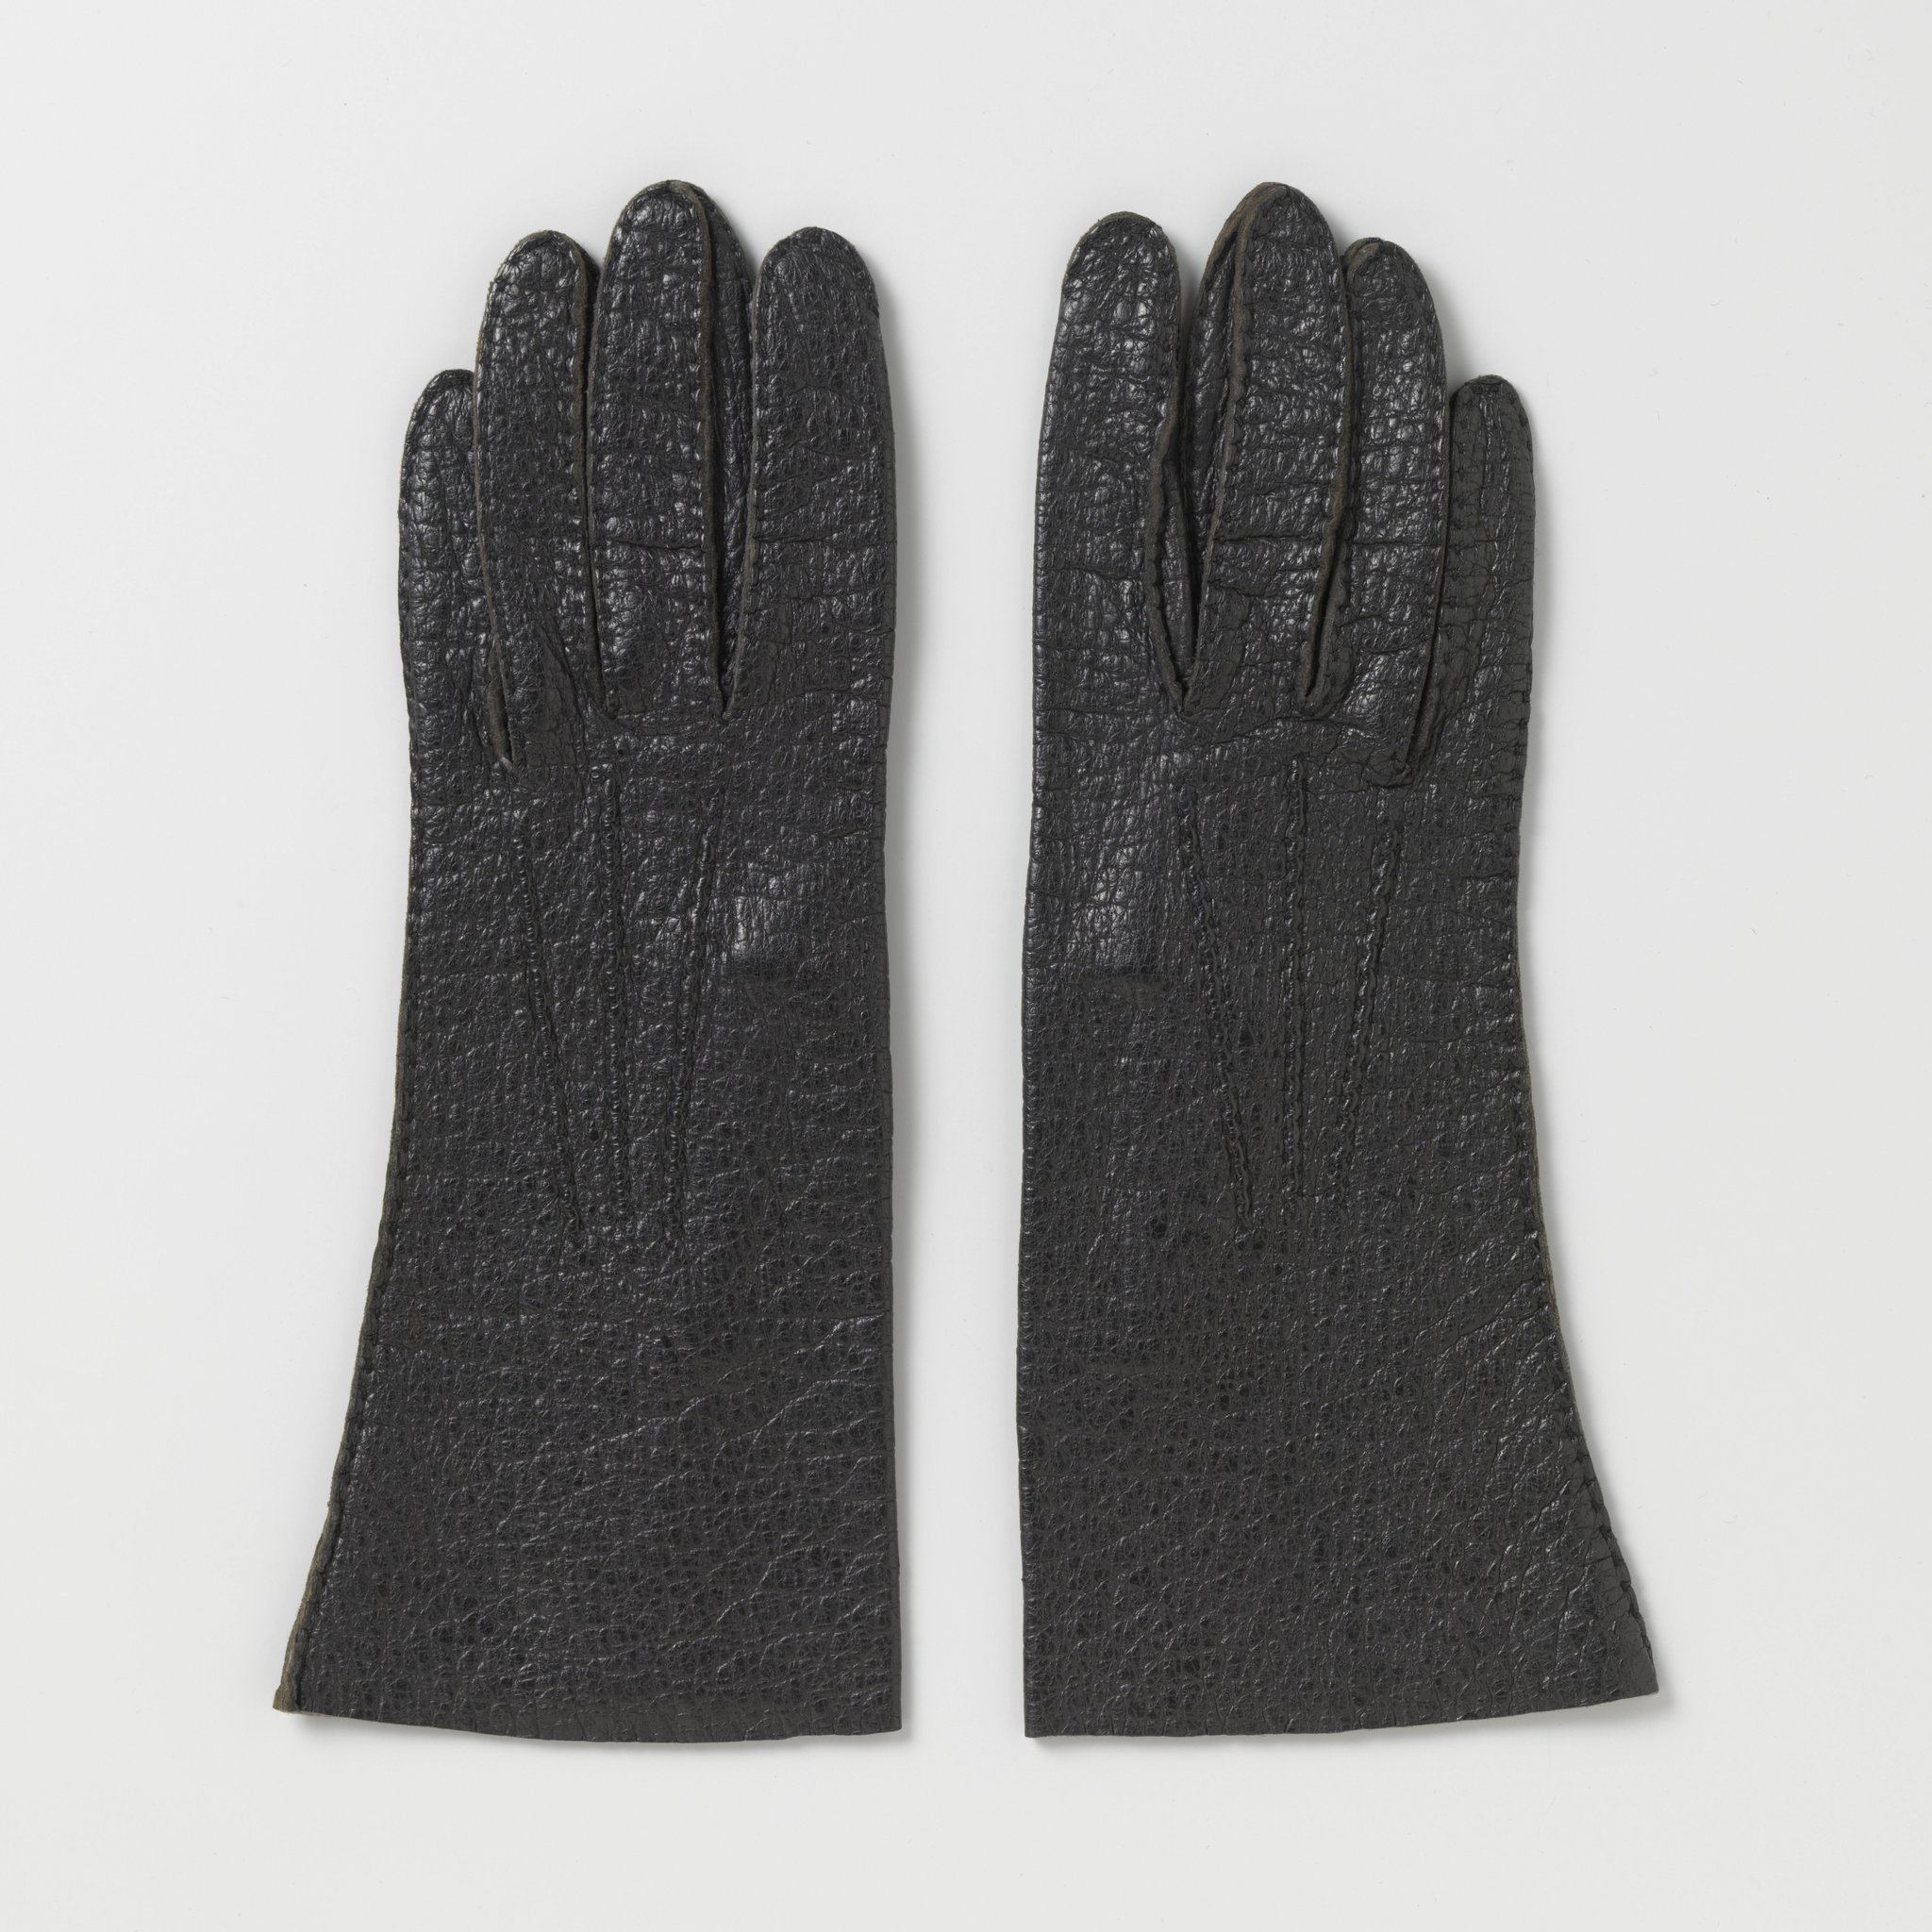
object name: clothing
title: Handschoen van zwart leer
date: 1900-1915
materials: leather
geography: netherlands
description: Linker handschoen van zwart leer met op de rug drie uitstralende koorden.